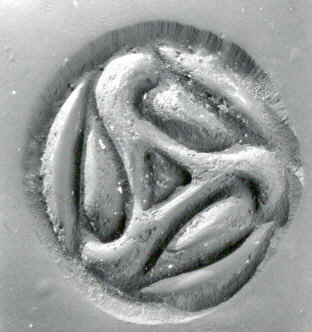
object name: stamp seal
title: Compartmented stamp seal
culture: bactria-margiana archaeological complex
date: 2333-1668 BCE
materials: faience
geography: bactria-margiana